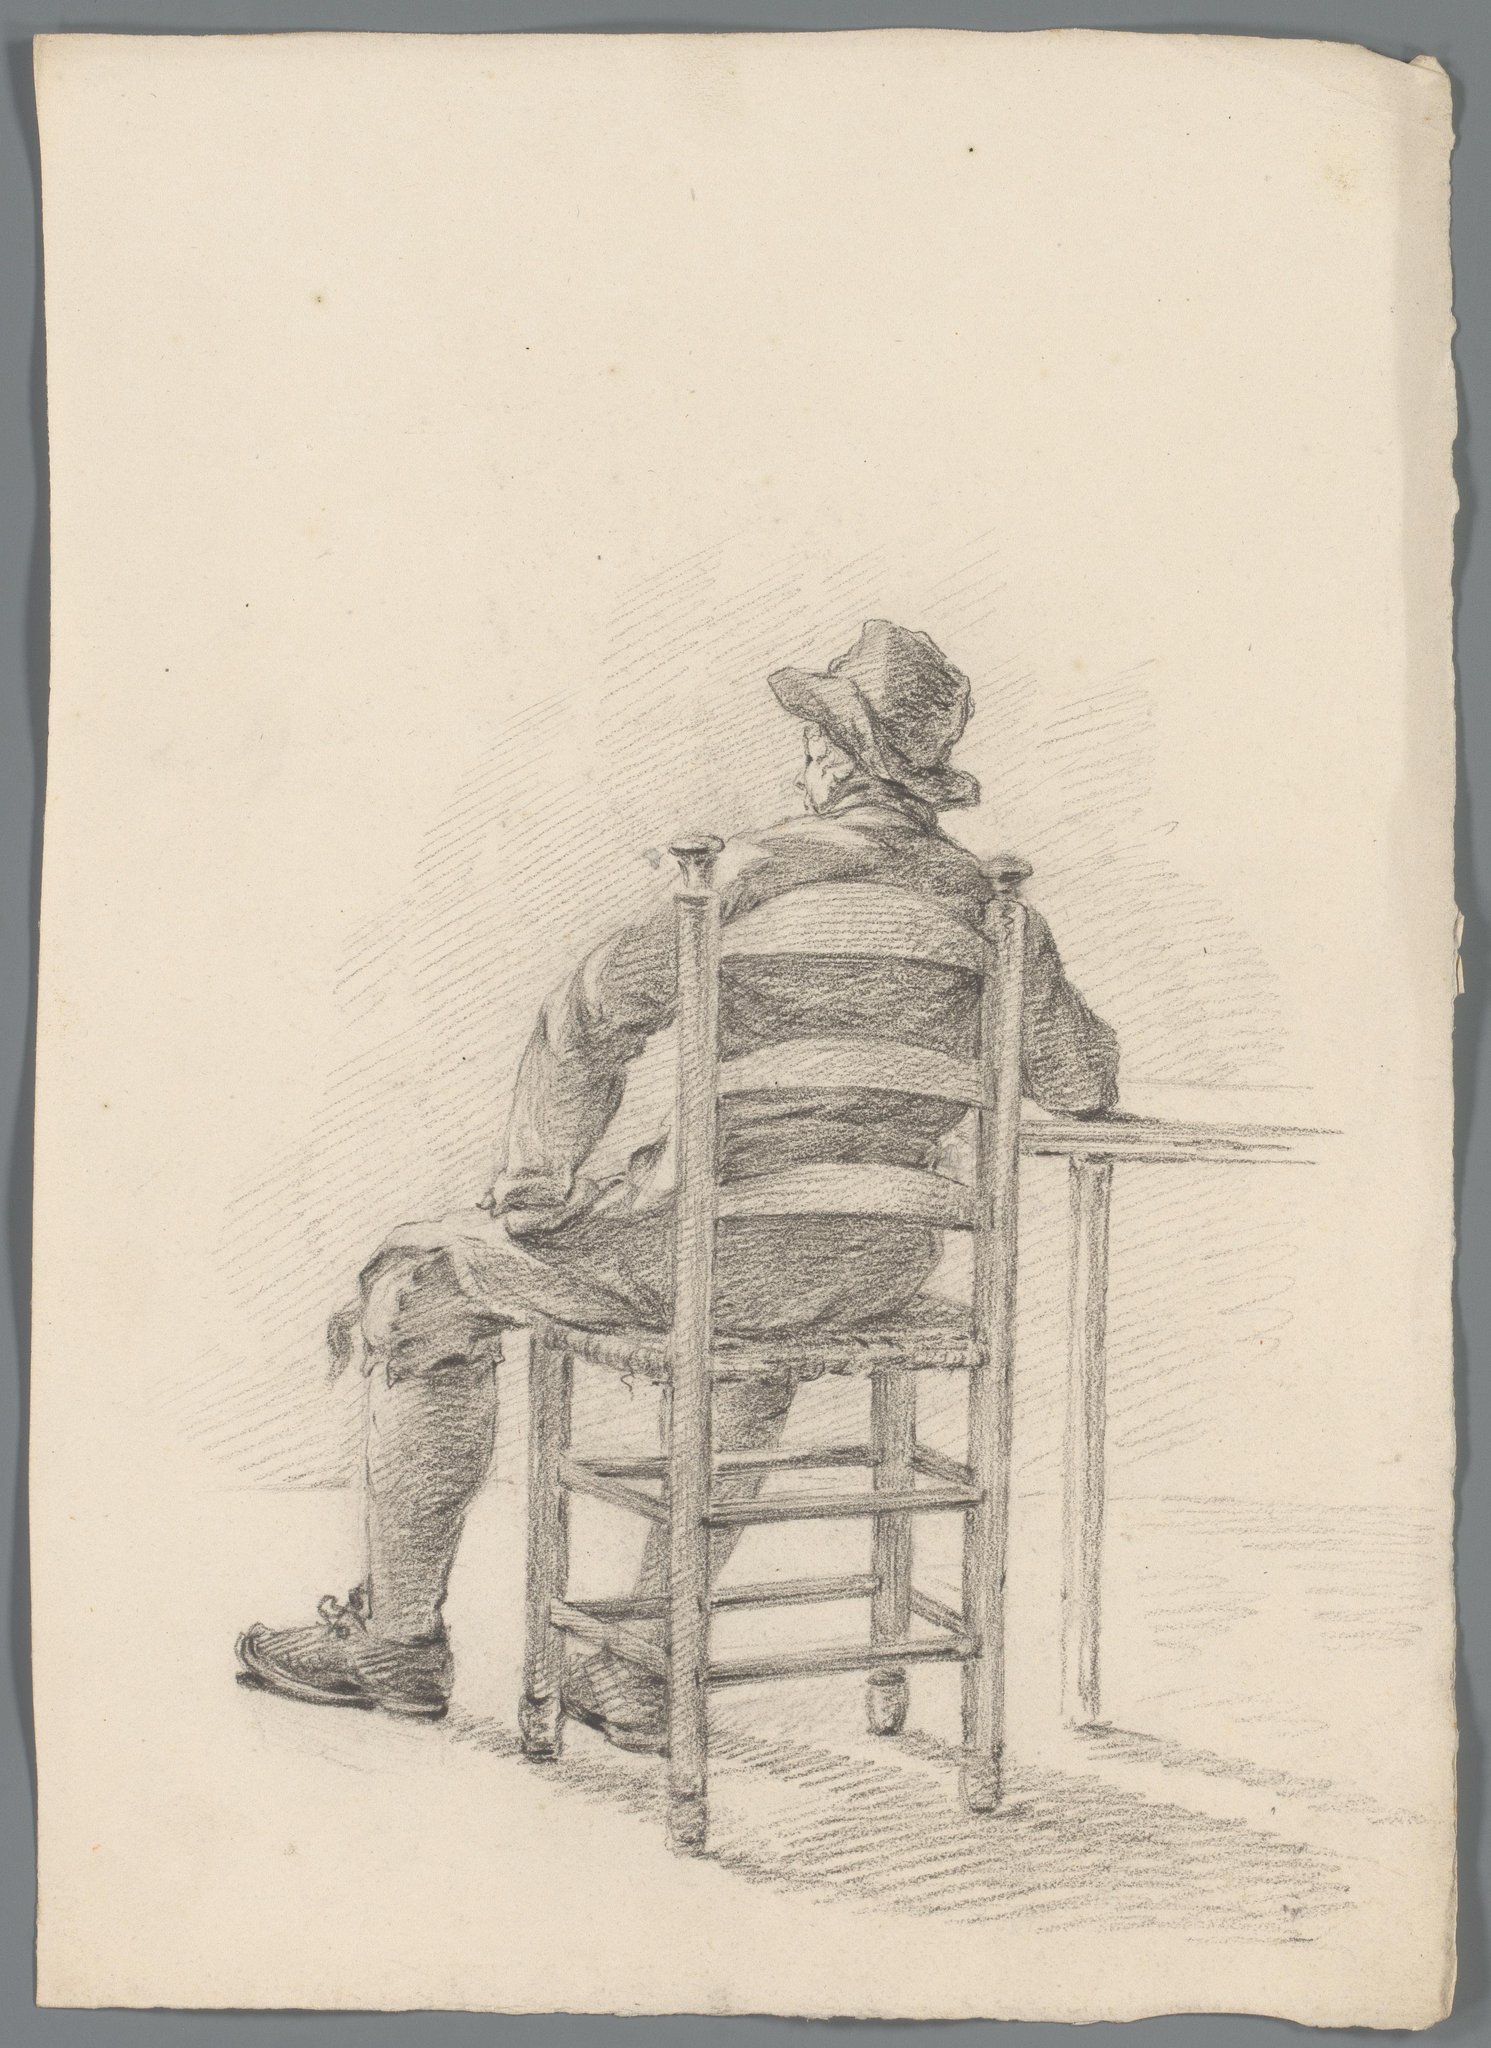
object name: drawing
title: Zittende man op een stoel, op de rug gezien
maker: Anonymous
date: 1820-1830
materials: chalk, paper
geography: the hague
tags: sitting figure, adult man, chair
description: Tekeningen waarschijnlijk ontstaan bij het Haagse kunstgenootschap ‘Tot Nut der Tekenkunst’, waar twee keer per week tekenavonden werden georganiseerd met geklede modellen.